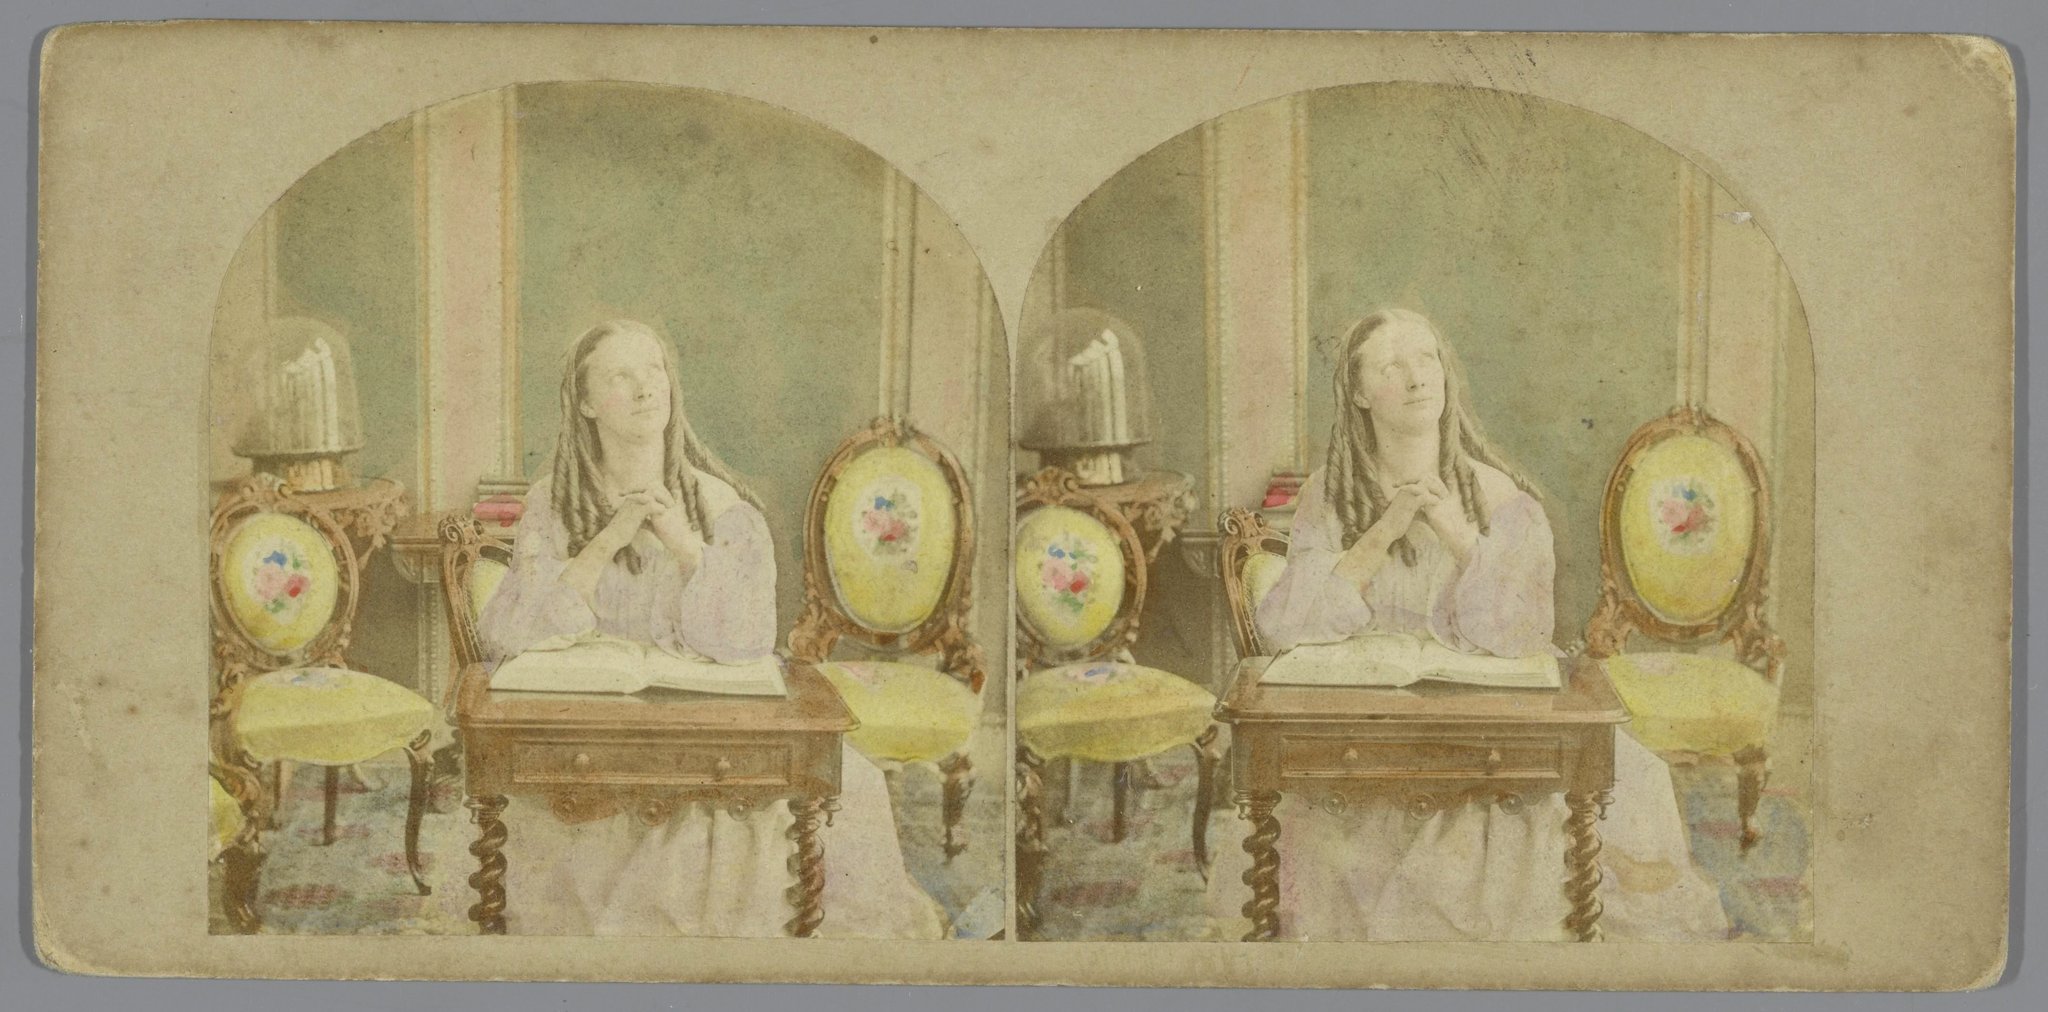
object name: stereograph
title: Biddende vrouw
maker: Anonymous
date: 1852-1863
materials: cardboard, paper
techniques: albumen print, hand coloring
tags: adolescent, young woman, maiden, one person praying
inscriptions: copyright notice: ‘Copyright.’